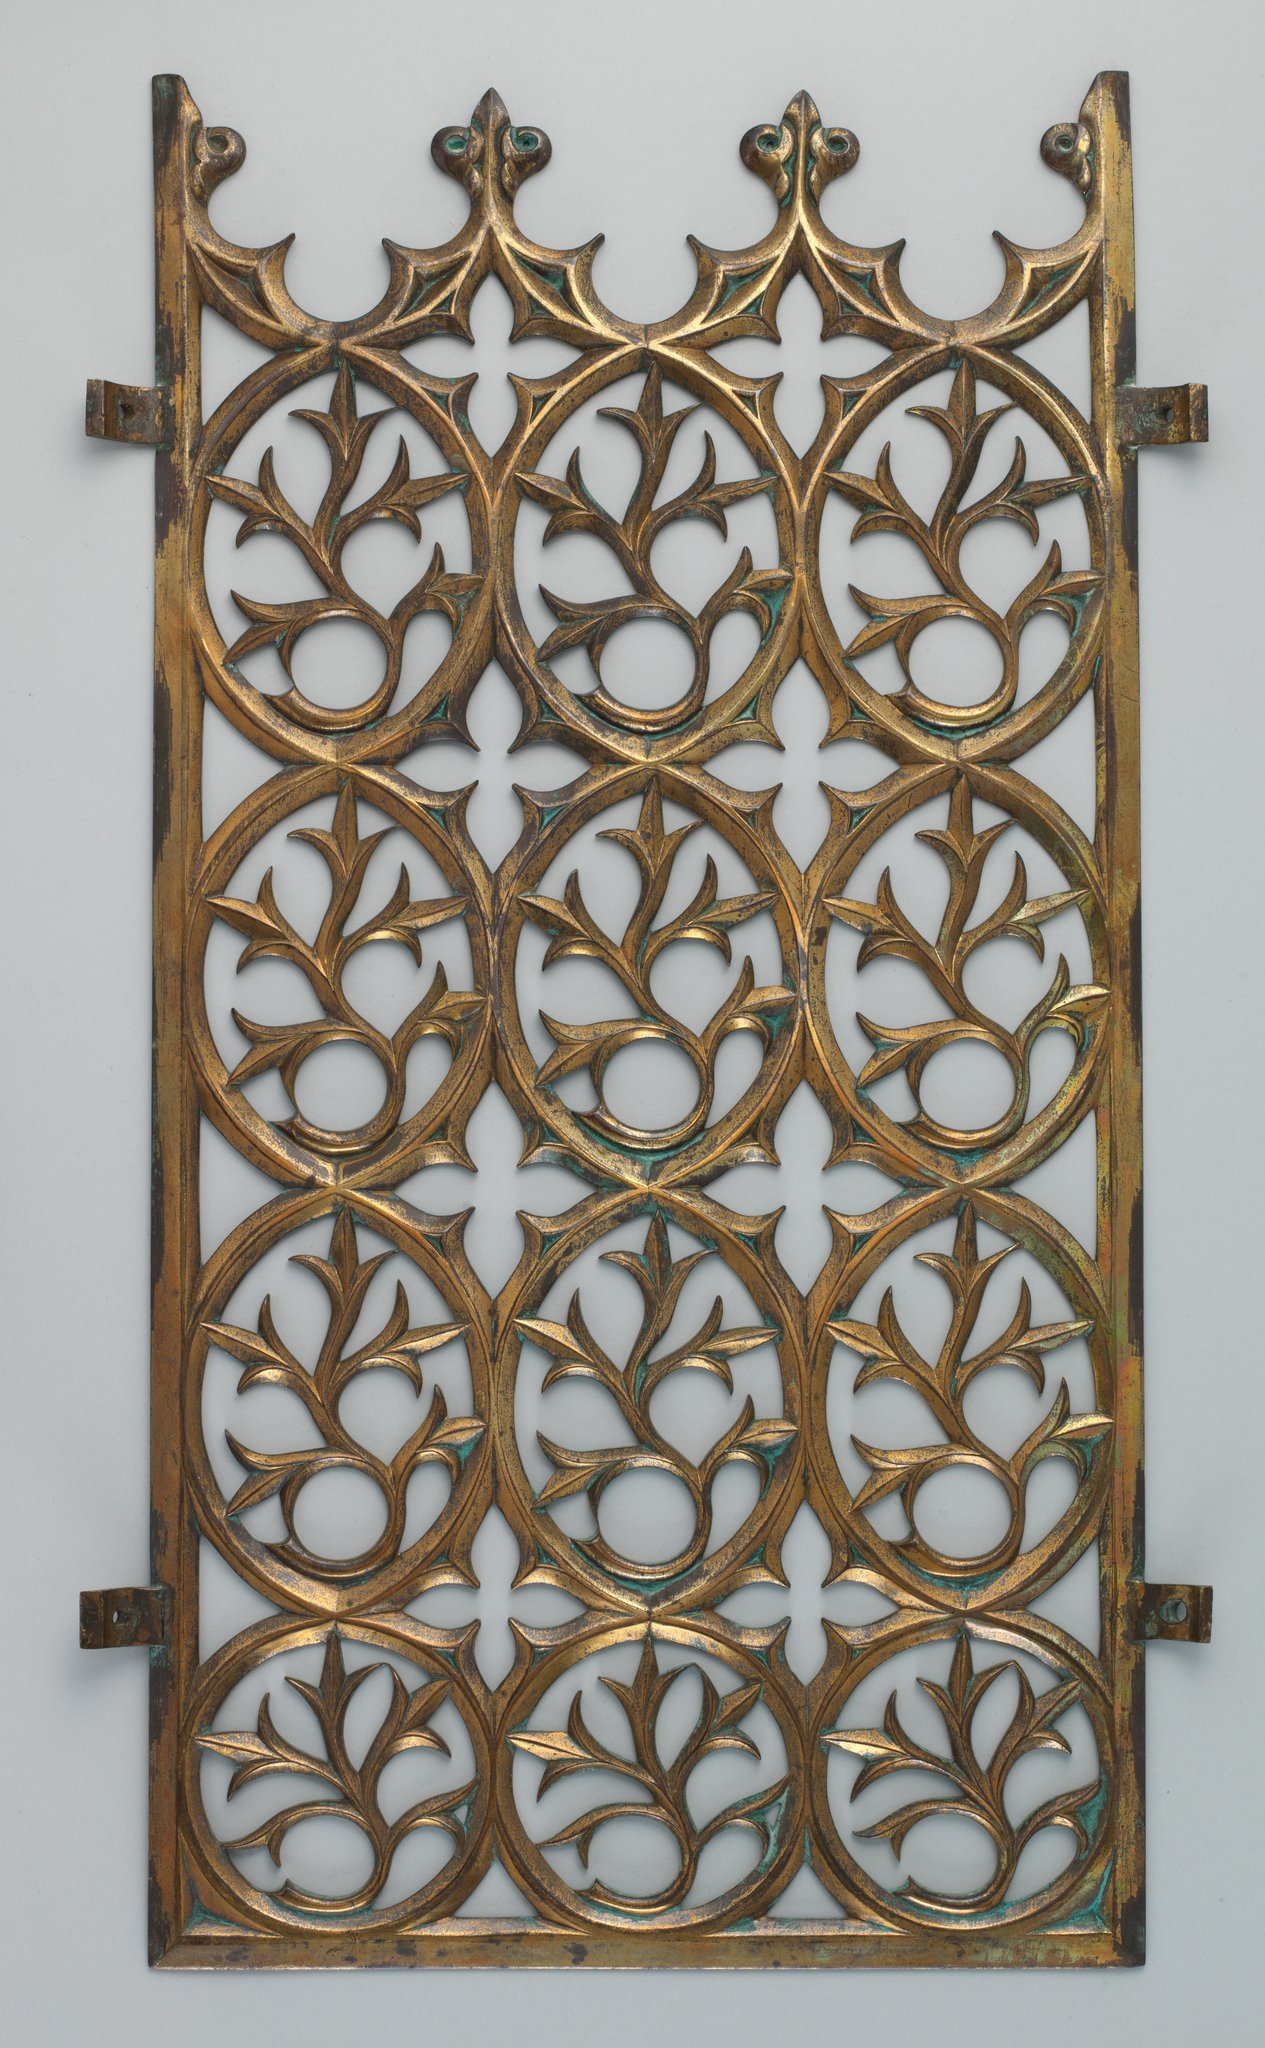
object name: grill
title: Decorative grill from the Palace of Westminster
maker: augustus welby northmore pugin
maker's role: designer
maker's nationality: british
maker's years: 1812-1852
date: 1845-1859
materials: brass